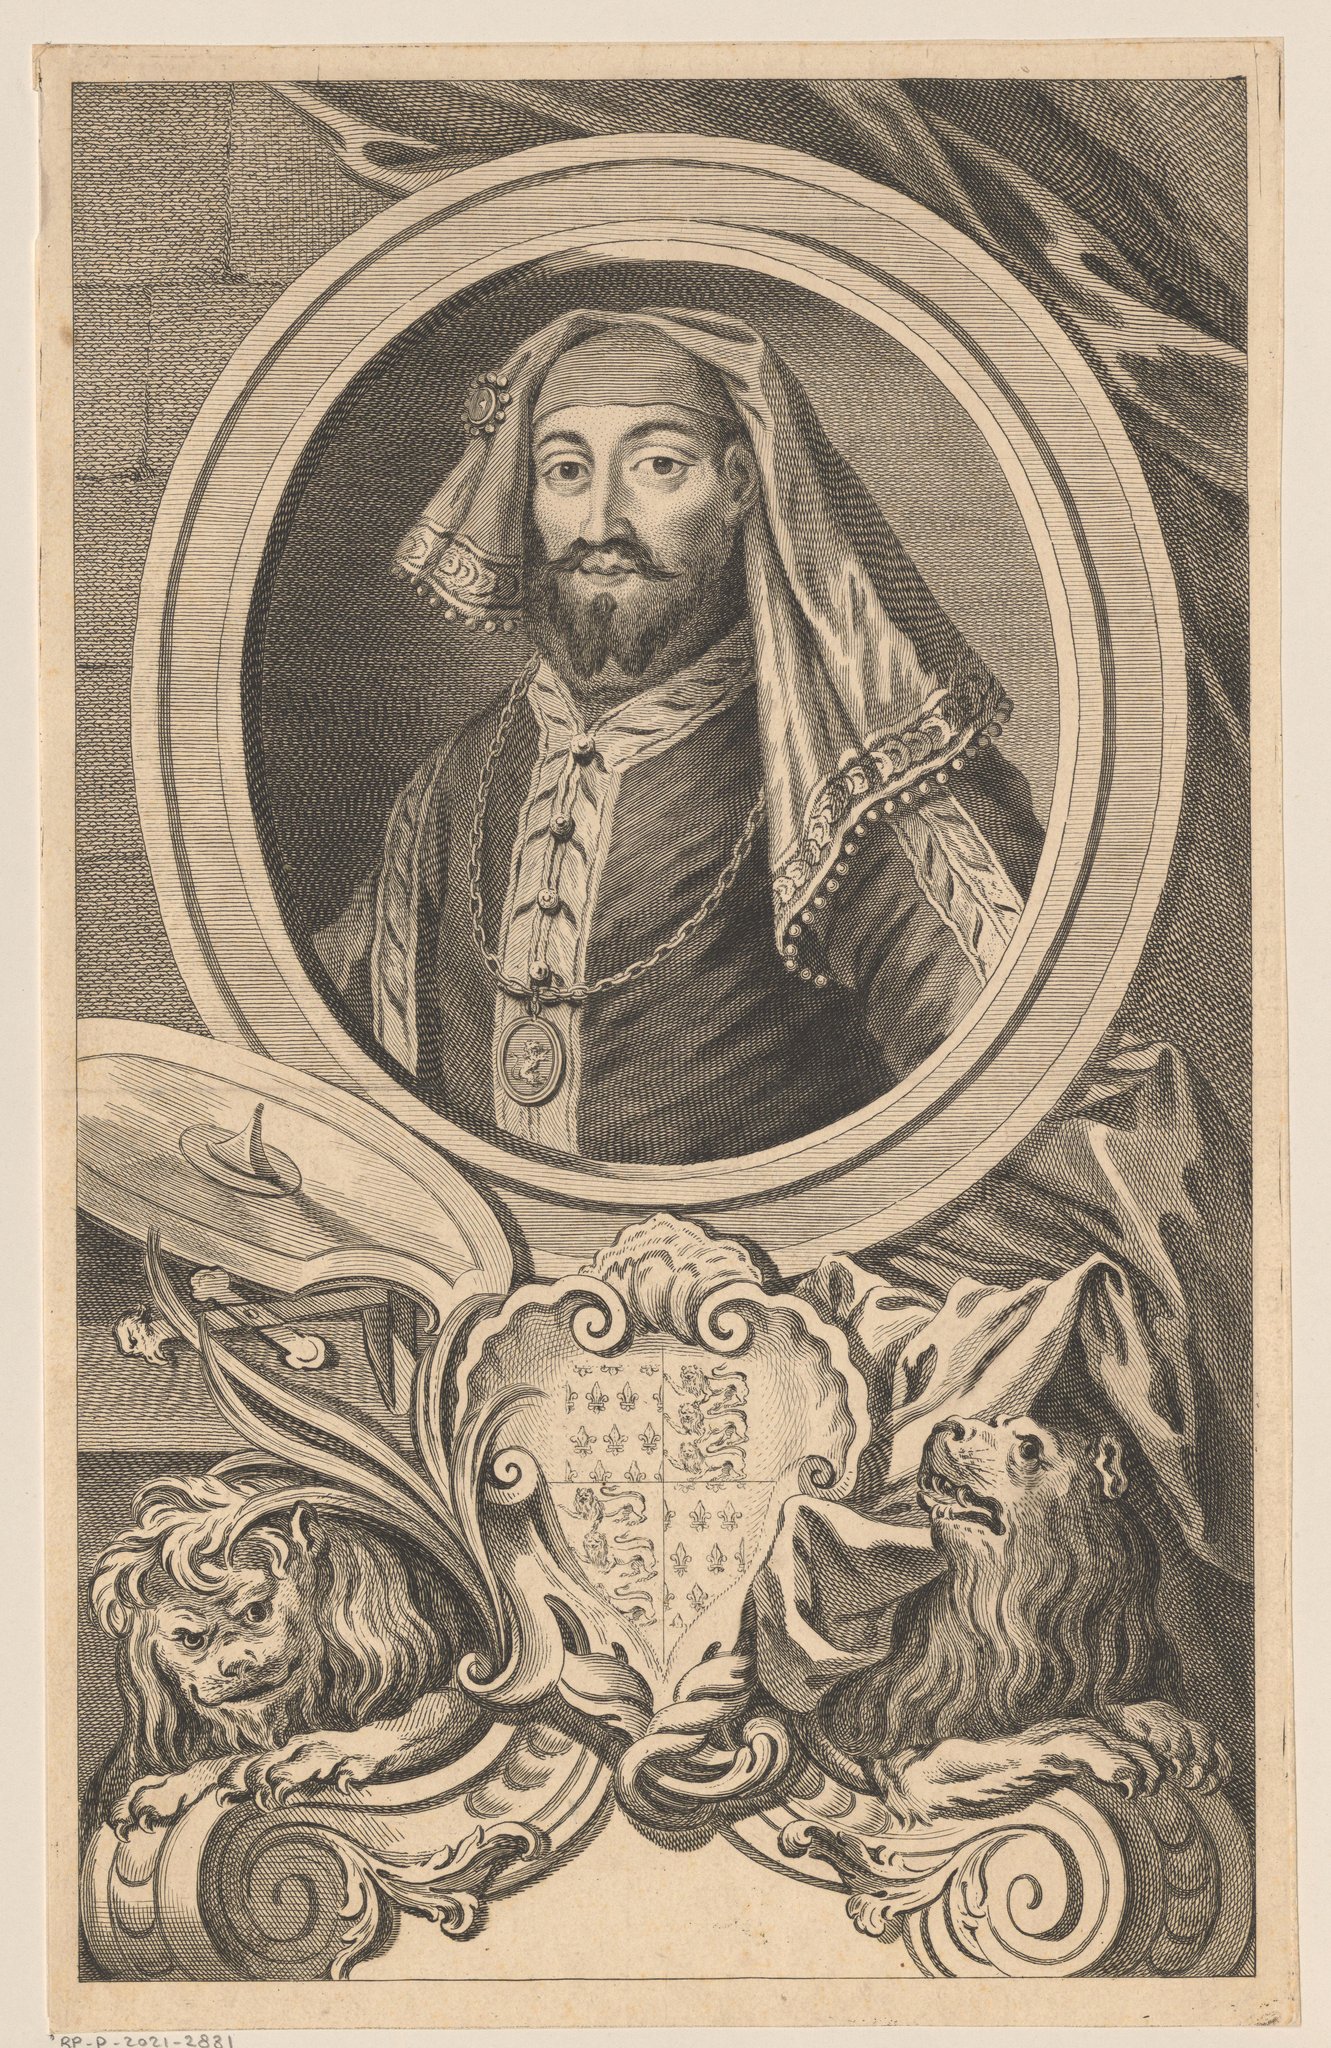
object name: print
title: Portret van Hendrik IV, koning van Engeland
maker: Anonymous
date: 1700-1749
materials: paper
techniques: engraving, etching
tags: historical persons, beasts of prey, predatory animals: lion, king, armorial bearing, heraldry